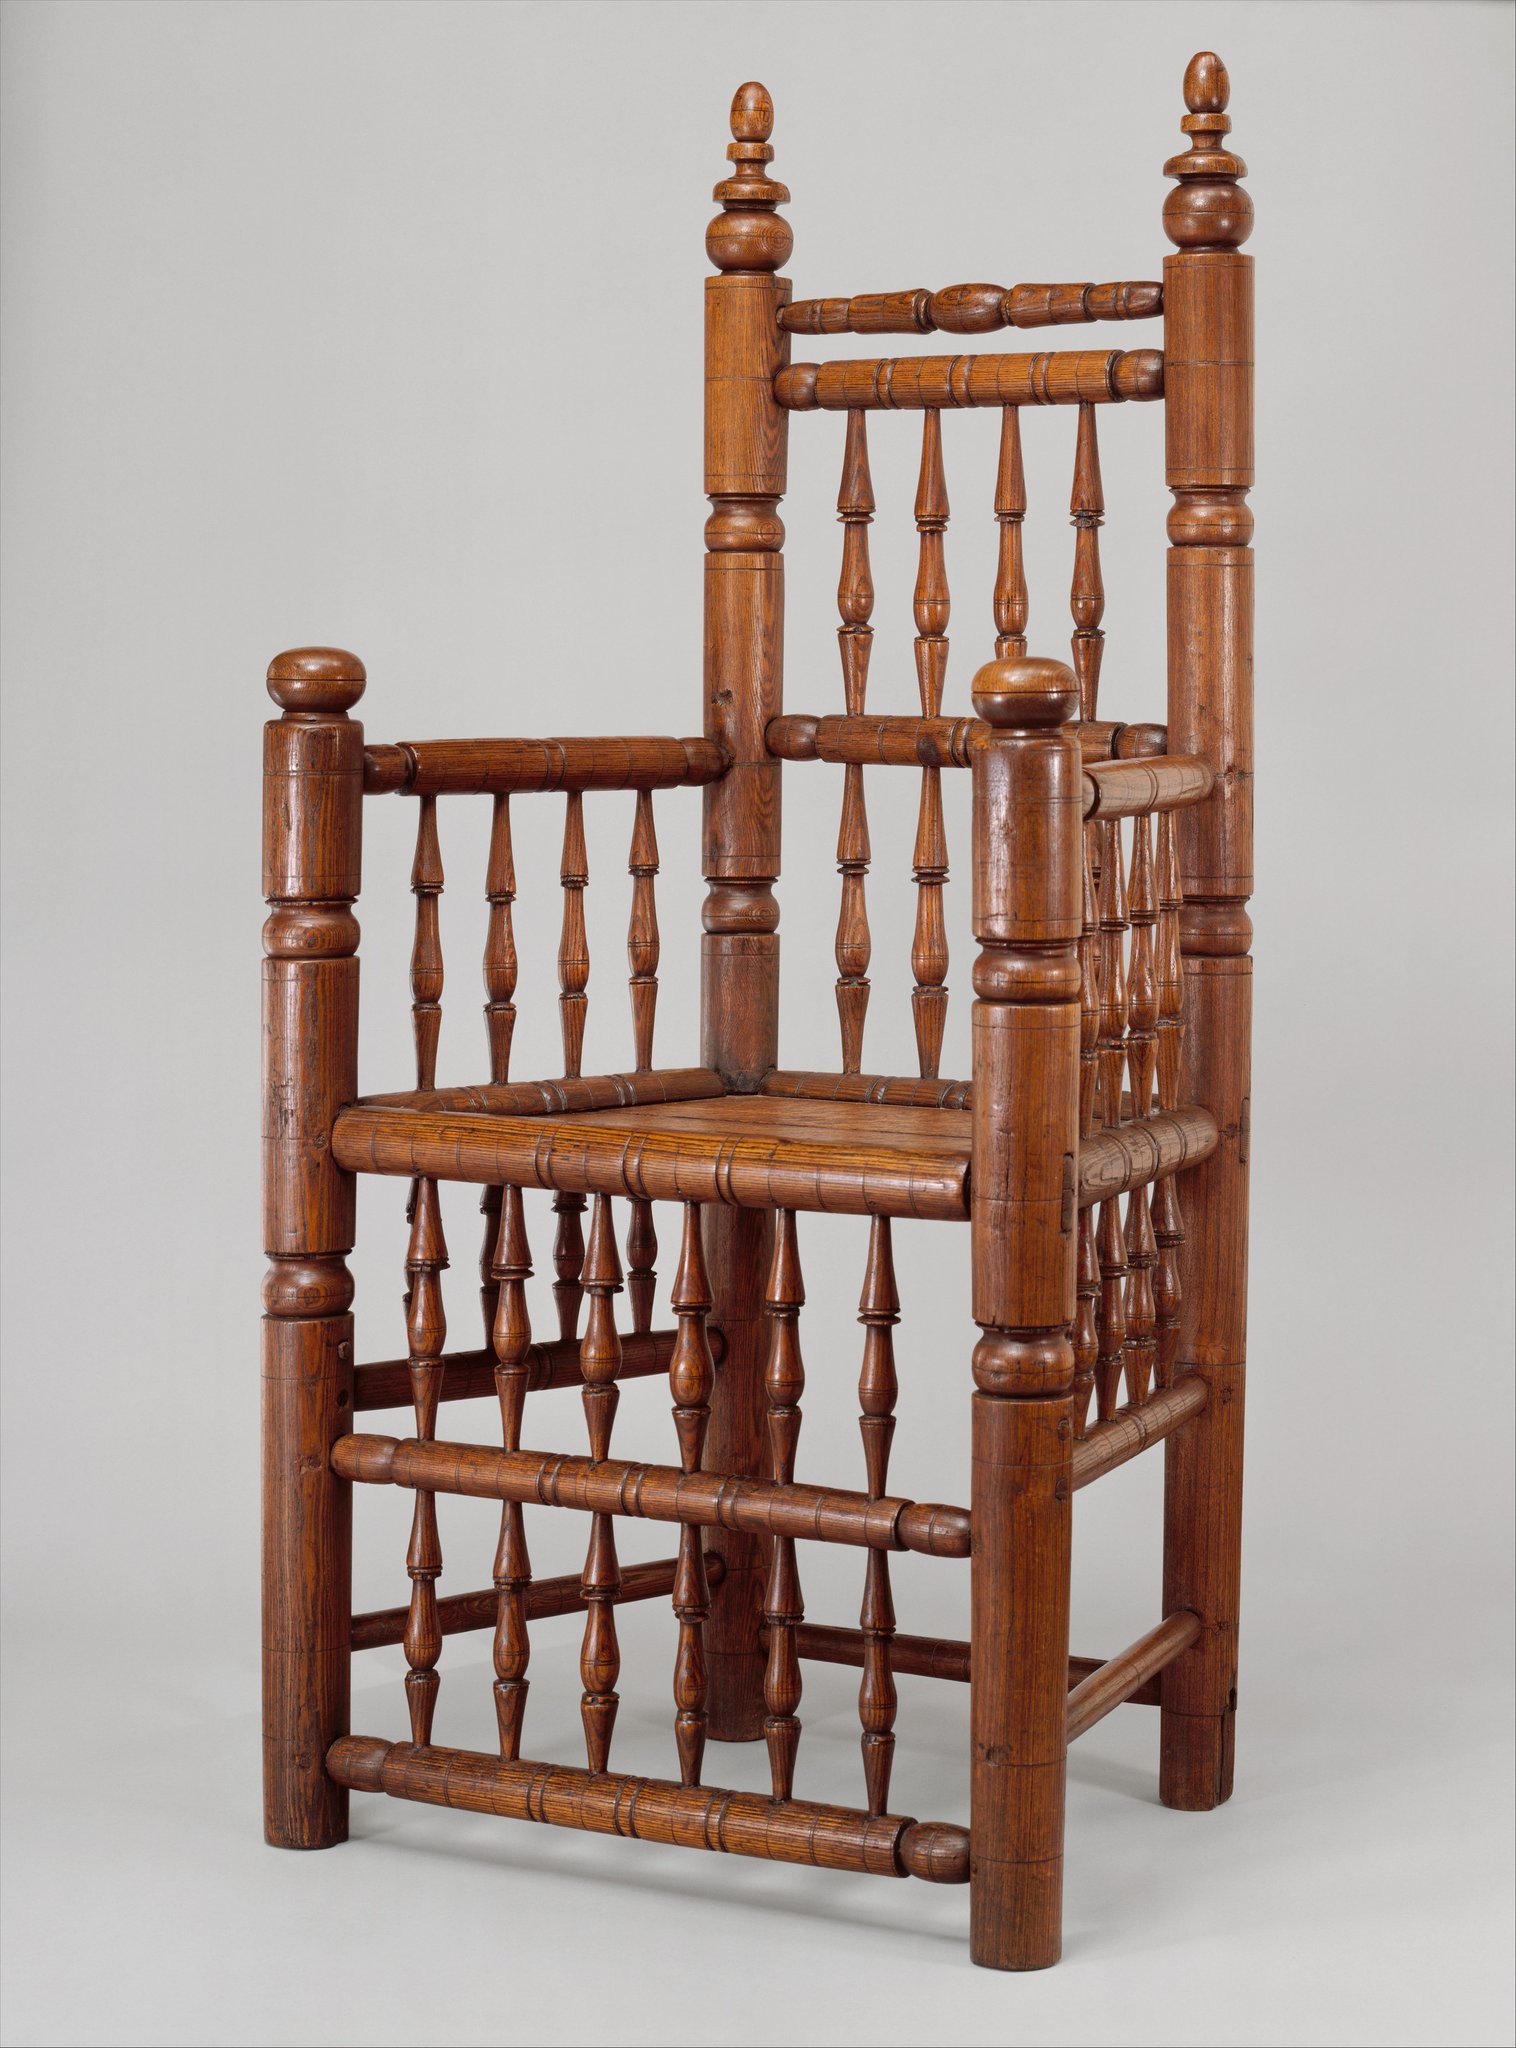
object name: armchair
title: Spindle-back armchair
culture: american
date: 1640-1680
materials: wood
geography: united states